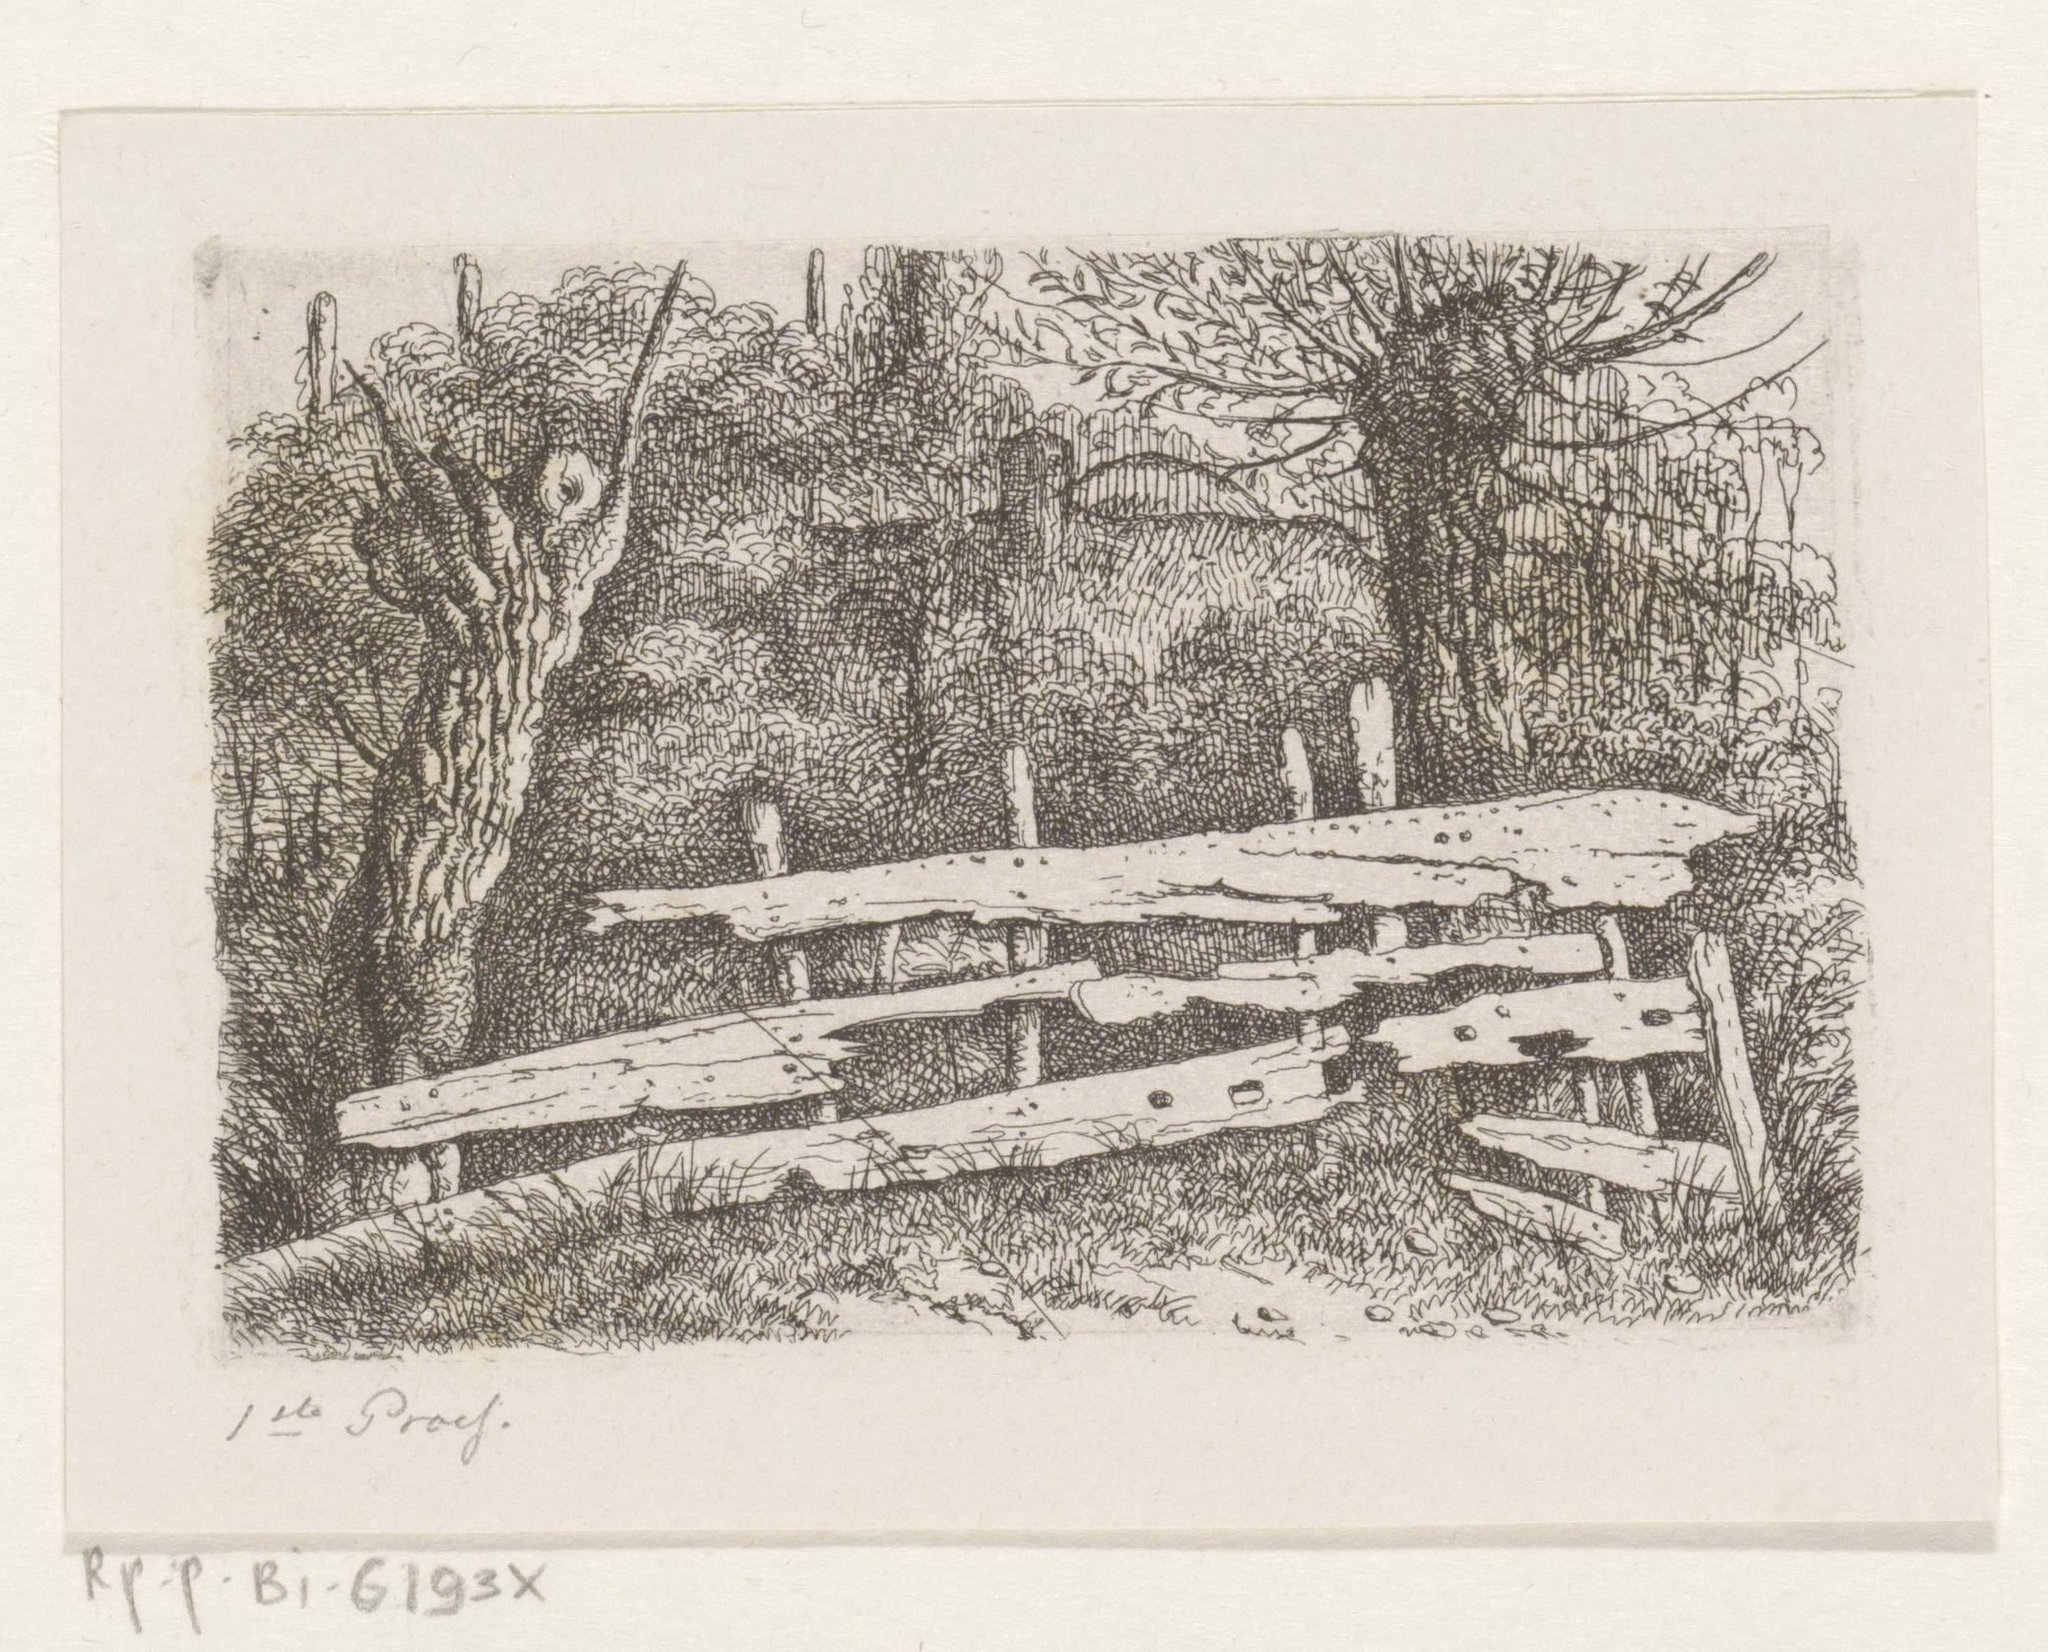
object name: print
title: Knotwilgen met hekje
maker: jacobus ludovicus cornet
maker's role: draughtsman, print maker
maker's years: 1815-1882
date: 1825-1882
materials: paper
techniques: etching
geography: leiden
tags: fence, wall, paling, trees: willow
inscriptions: collector's mark: Lugt 2166